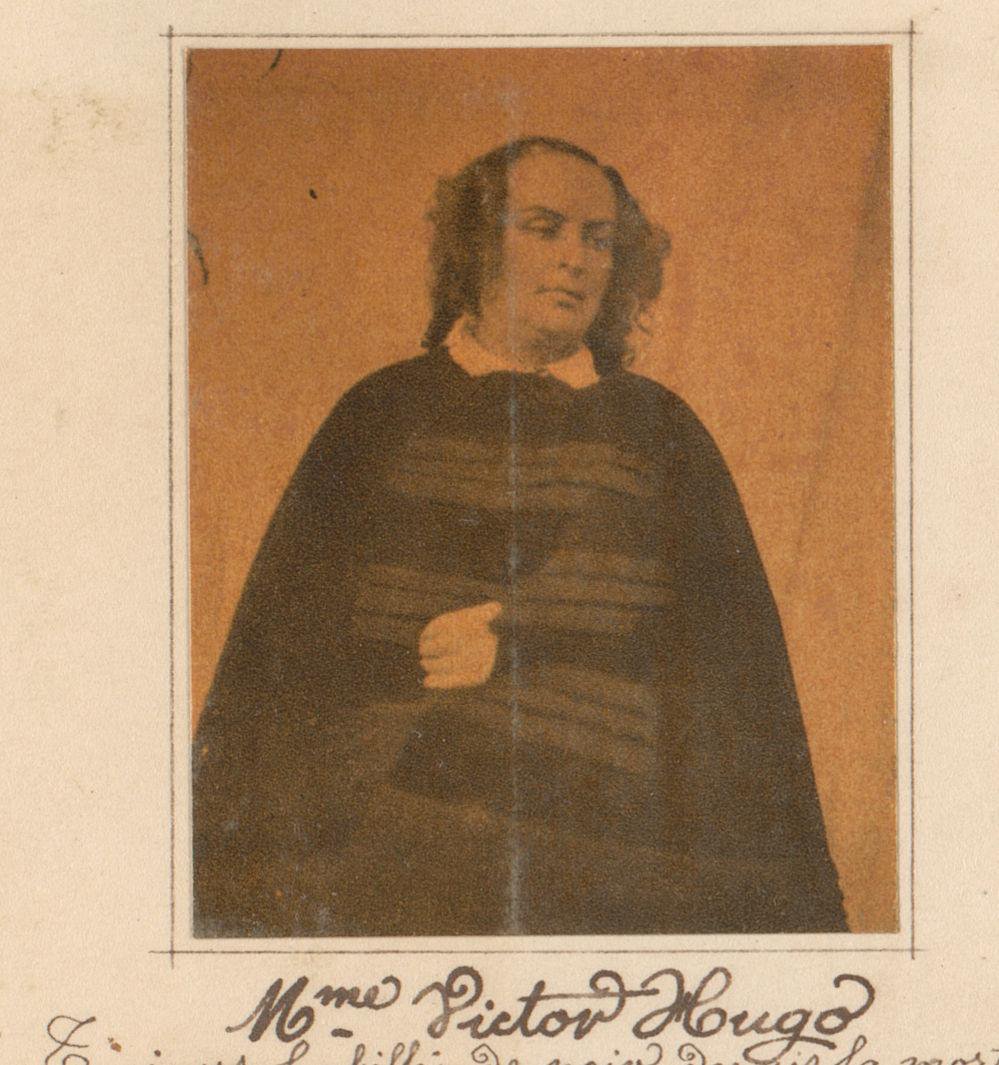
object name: album leaf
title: Portret van Adèle Foucher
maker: Anonymous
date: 1845-1853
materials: paper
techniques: rotogravure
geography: france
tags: paris, brussels, writer, poet, author, france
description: Deze prent maakt deel uit van een album.